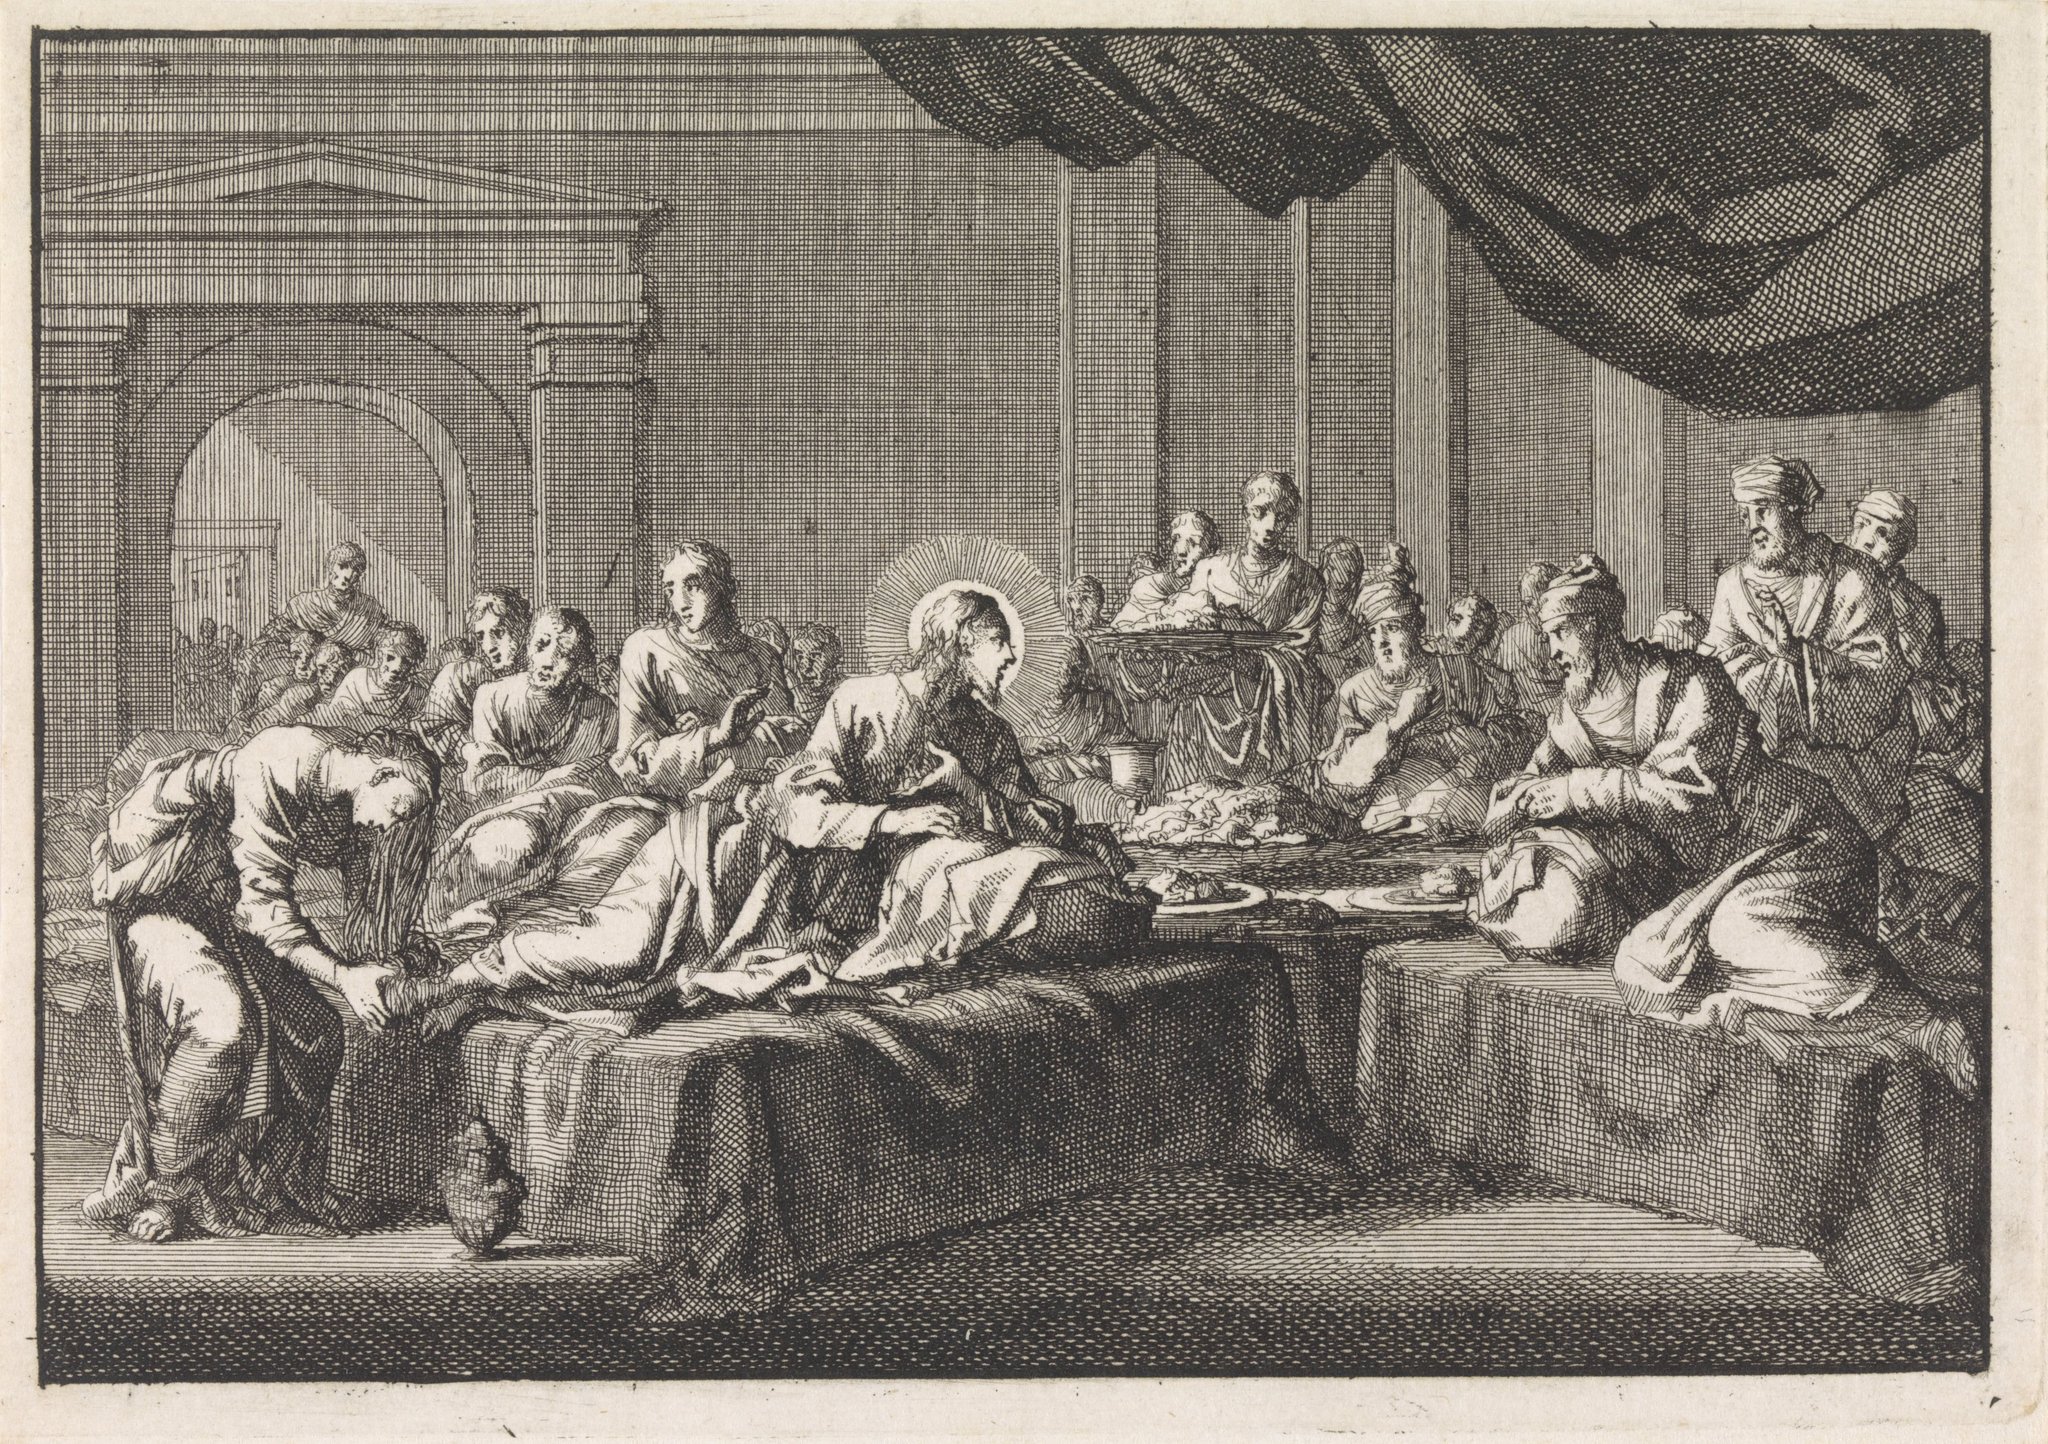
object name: print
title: Maria Magdalena wast de voeten van Christus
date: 1703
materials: paper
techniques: etching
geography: haarlem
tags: a woman washes christ's feet with her tears, and wipes them with her hair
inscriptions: collector's mark: Lugt 2228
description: Proefdruk van een boekillustratie voor David Martin. Historie des Ouden en Nieuwen Testaments. Amsterdam, Pieter Mortier, 1703. Deel II. De boekillustraties voor de Mortierbijbel hebben verschillende staten en kopieën, waarbij de chronologische volgorde moeilijk te achterhalen valt. Als boekillustraties werden ze bovendien herhaaldelijk opnieuw gebruikt voor andere boekwerken.